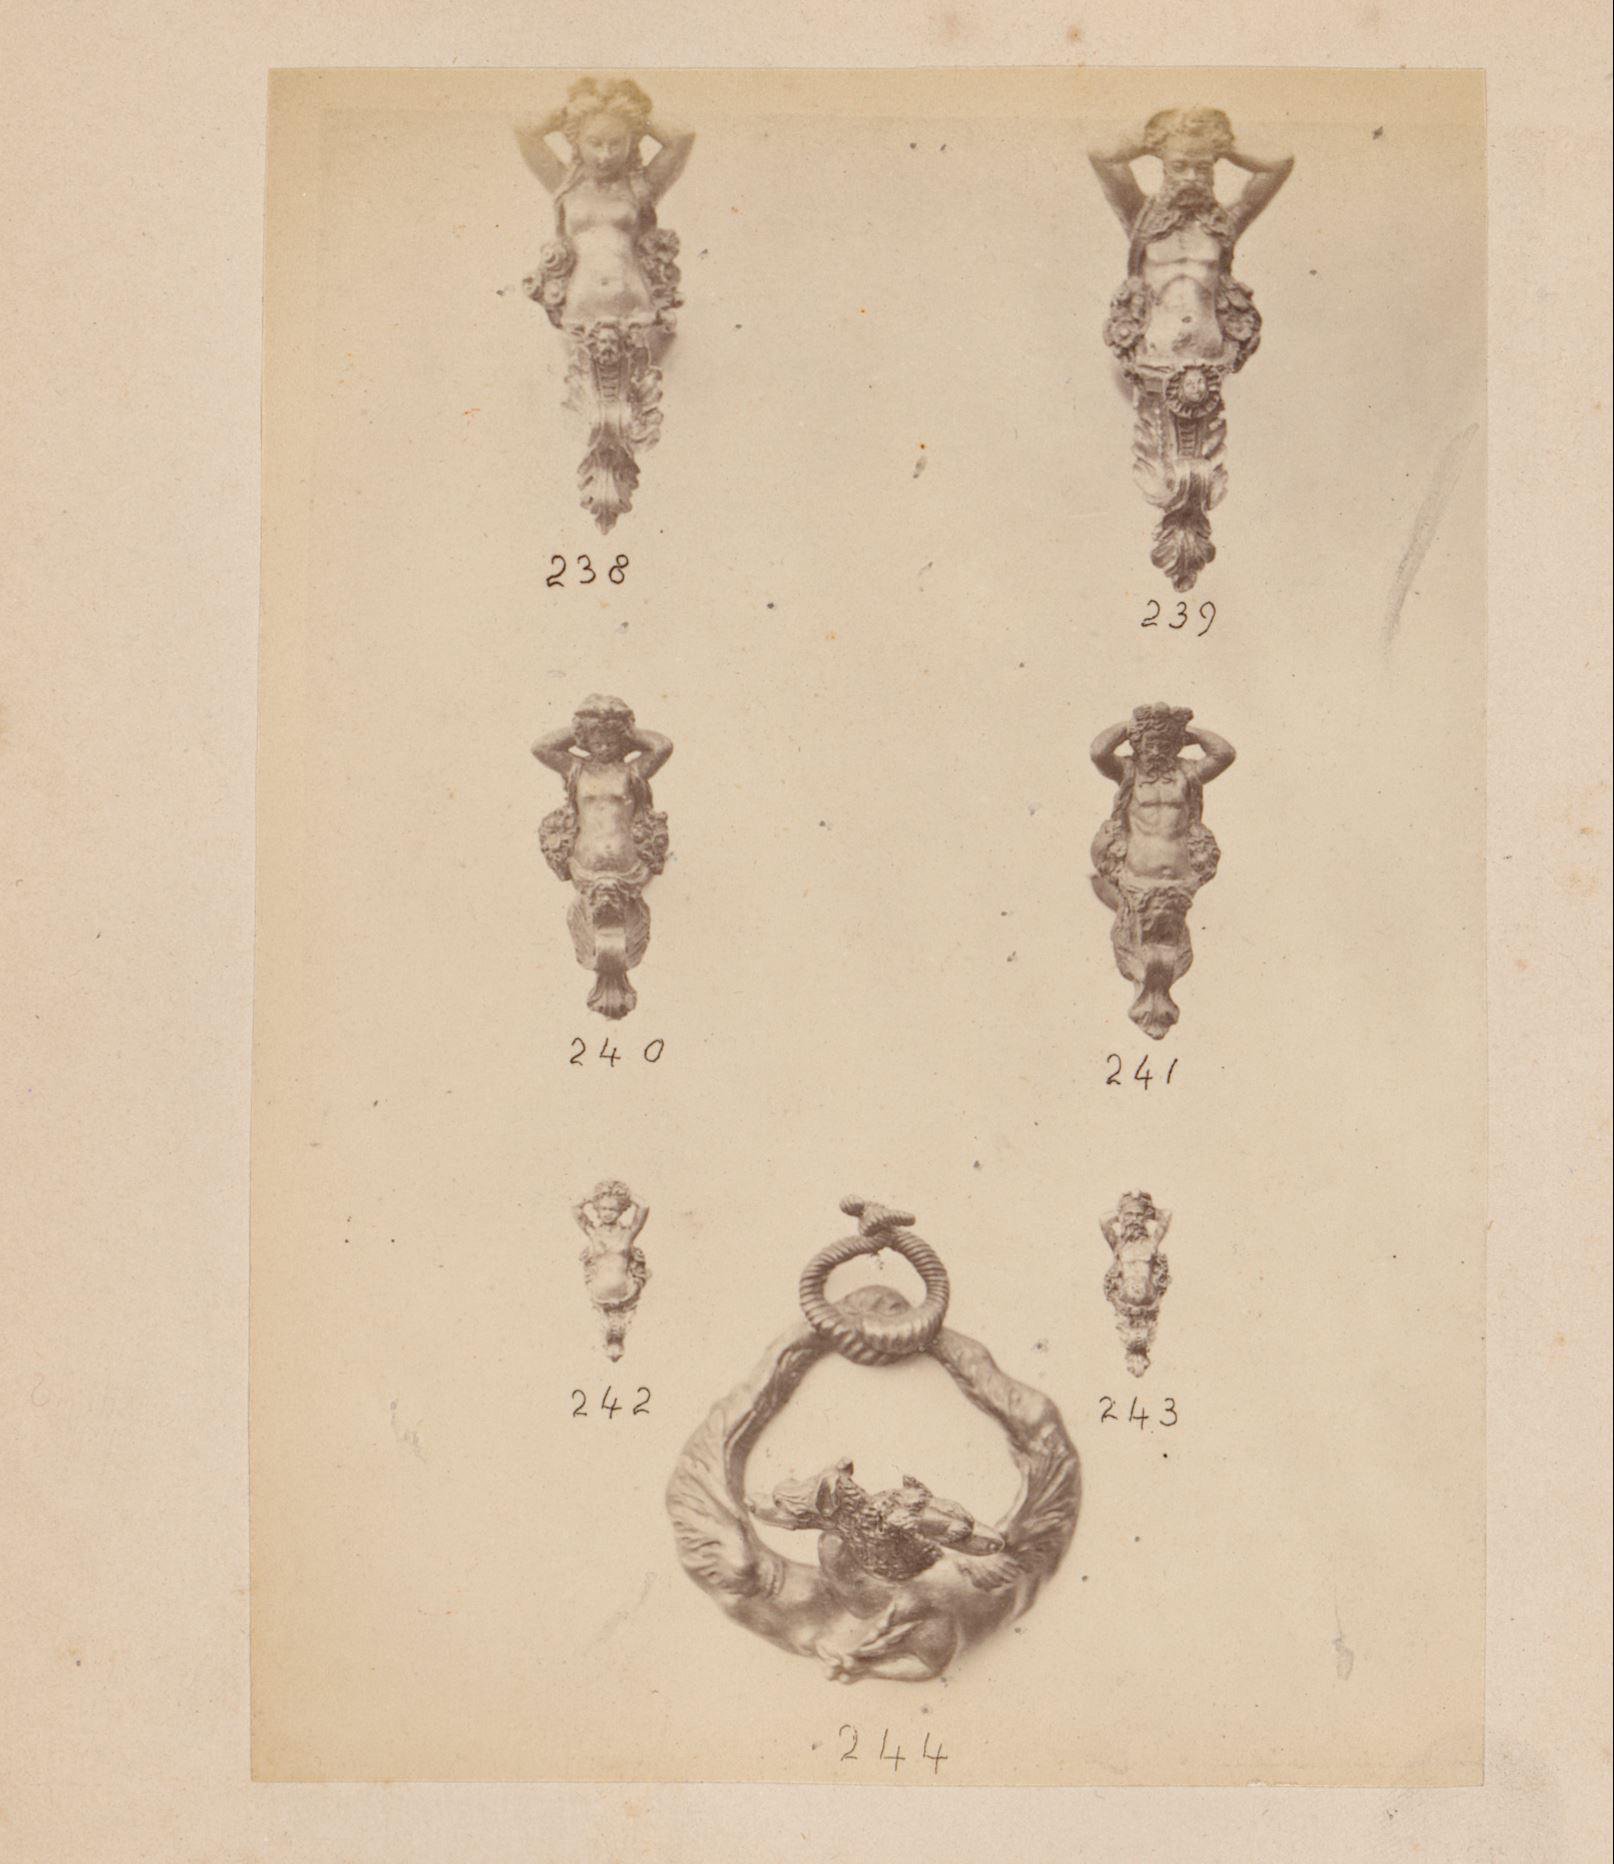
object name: page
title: Metalen sculpturen van naakten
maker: Anonymous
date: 1860-1885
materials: photographic support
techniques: albumen print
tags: the (nude) human figure; 'corpo humano' (ripa), sculpture